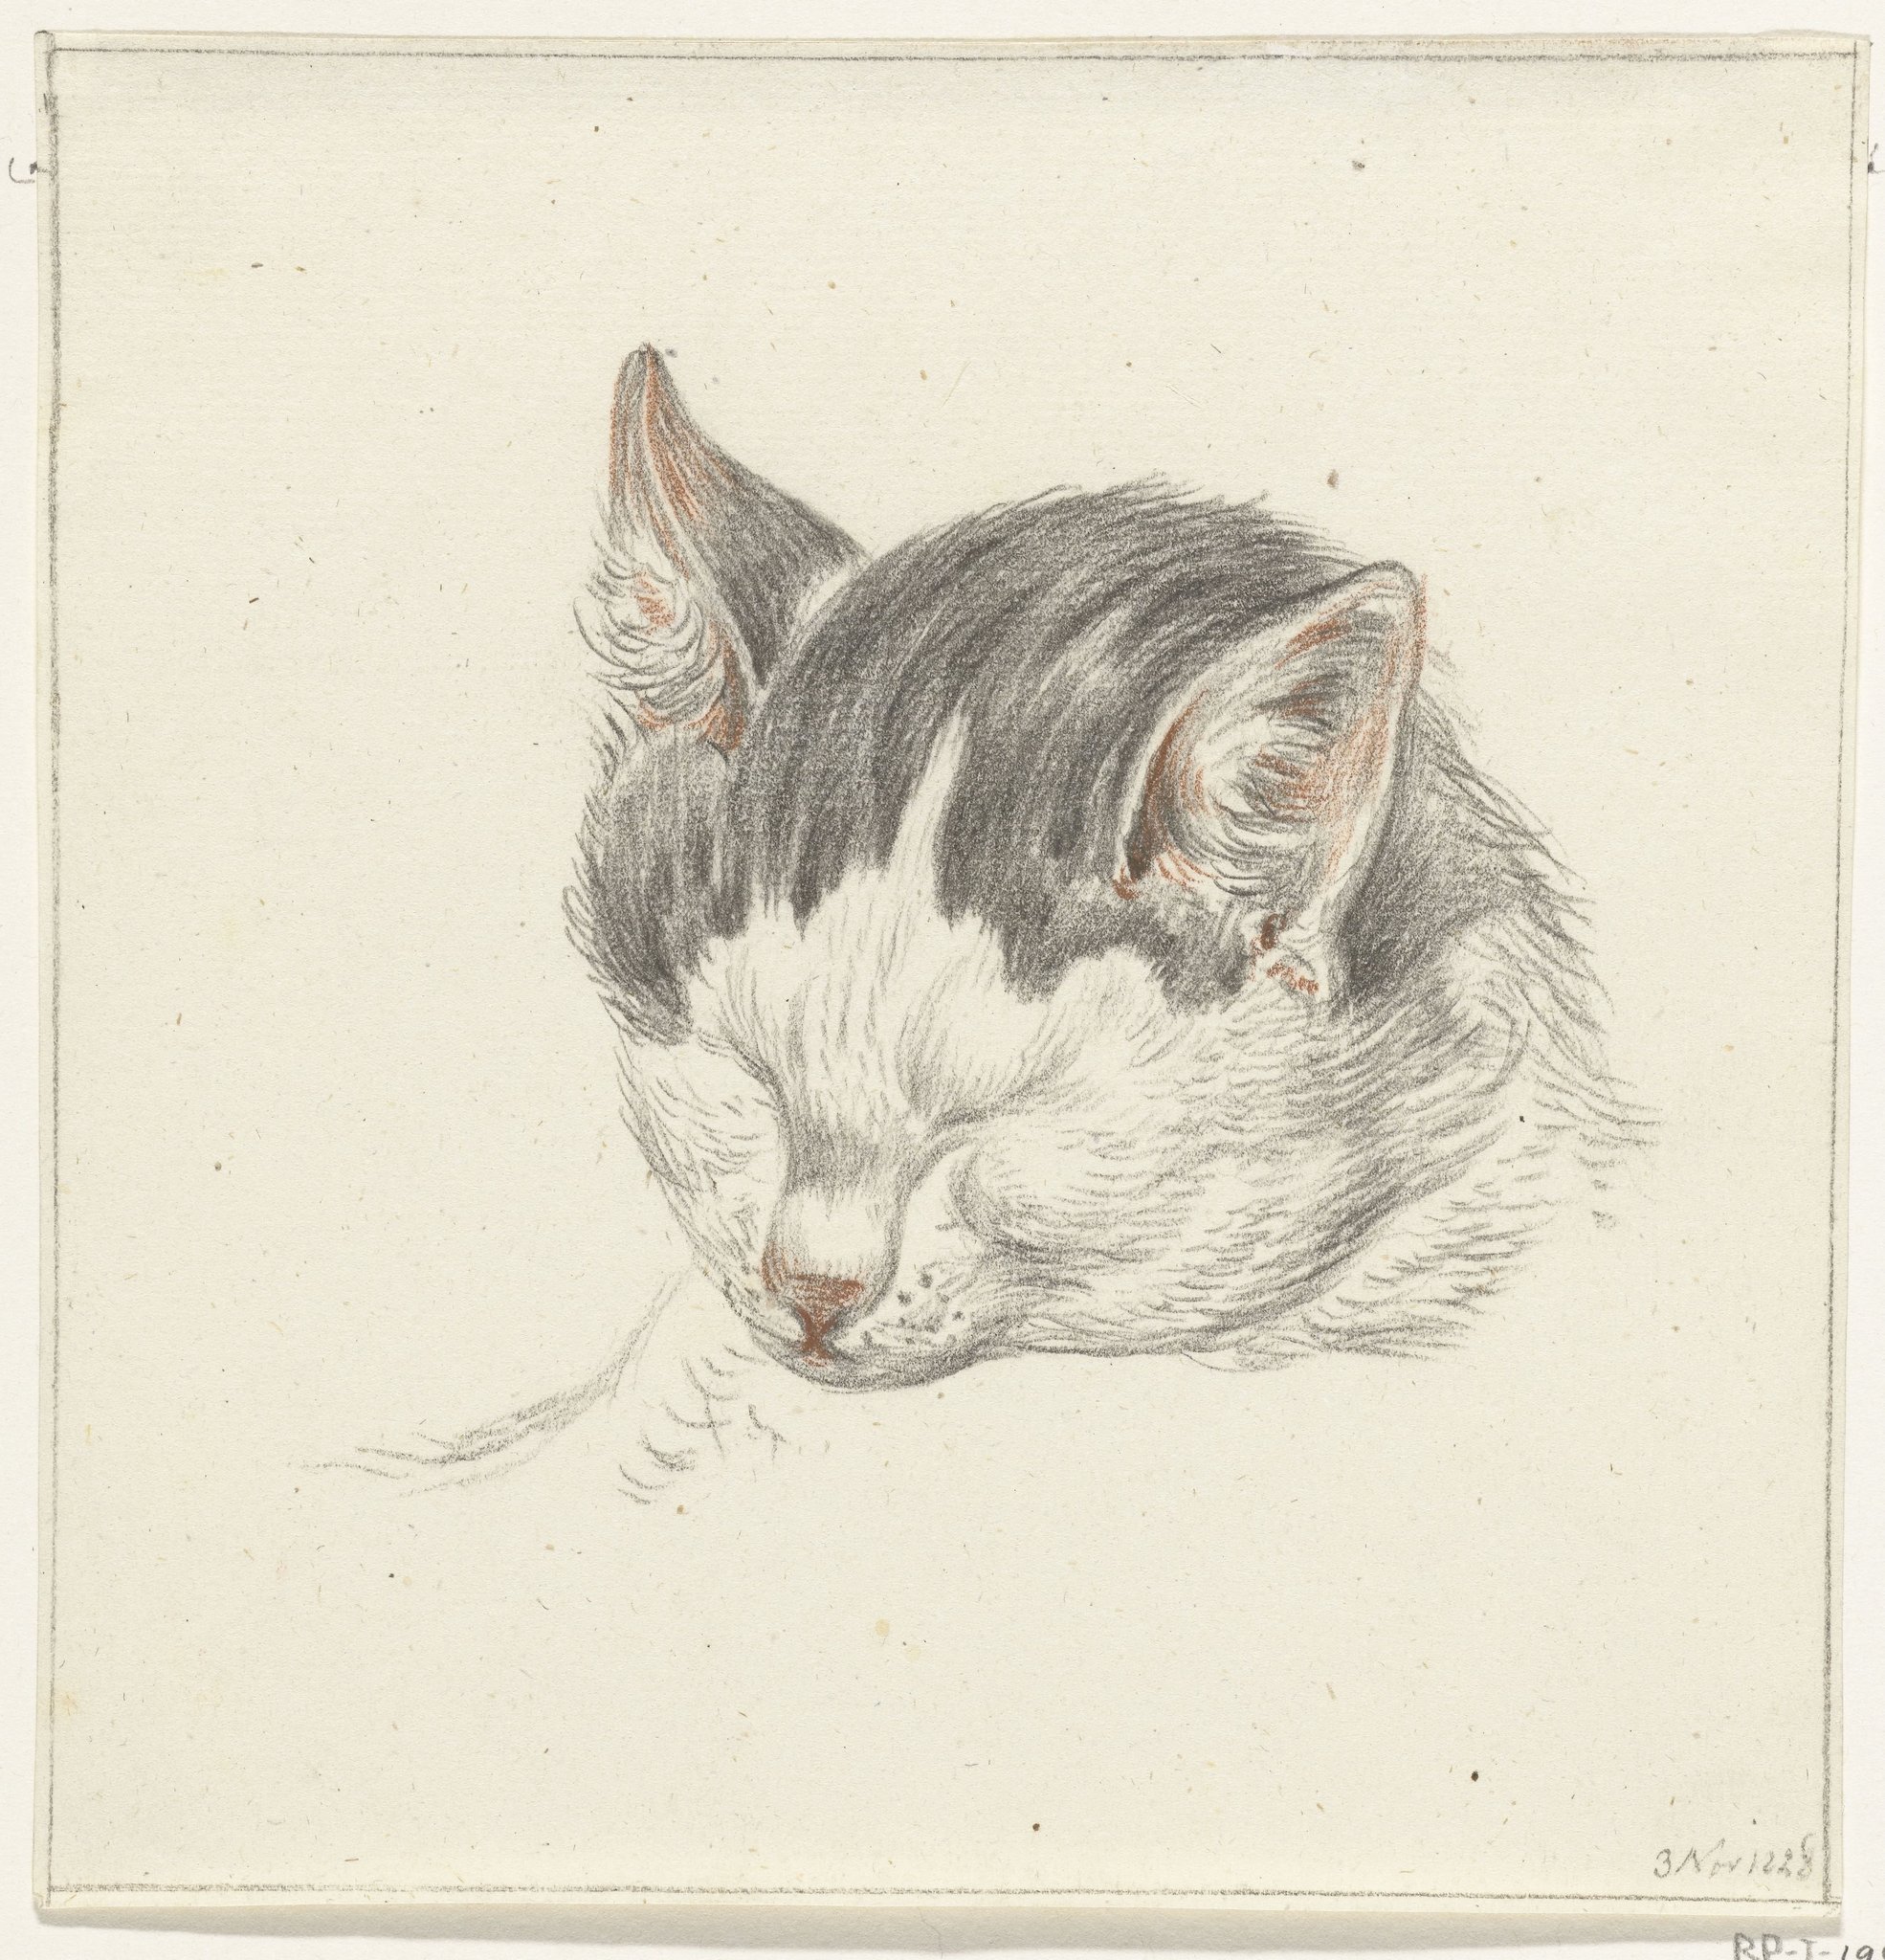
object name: drawing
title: Kop van een kat, van voren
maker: jean bernard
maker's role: draughtsman, print maker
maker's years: 1765-1833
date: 1828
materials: chalk, paper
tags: cat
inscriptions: date: ‘3 Nov 1828’